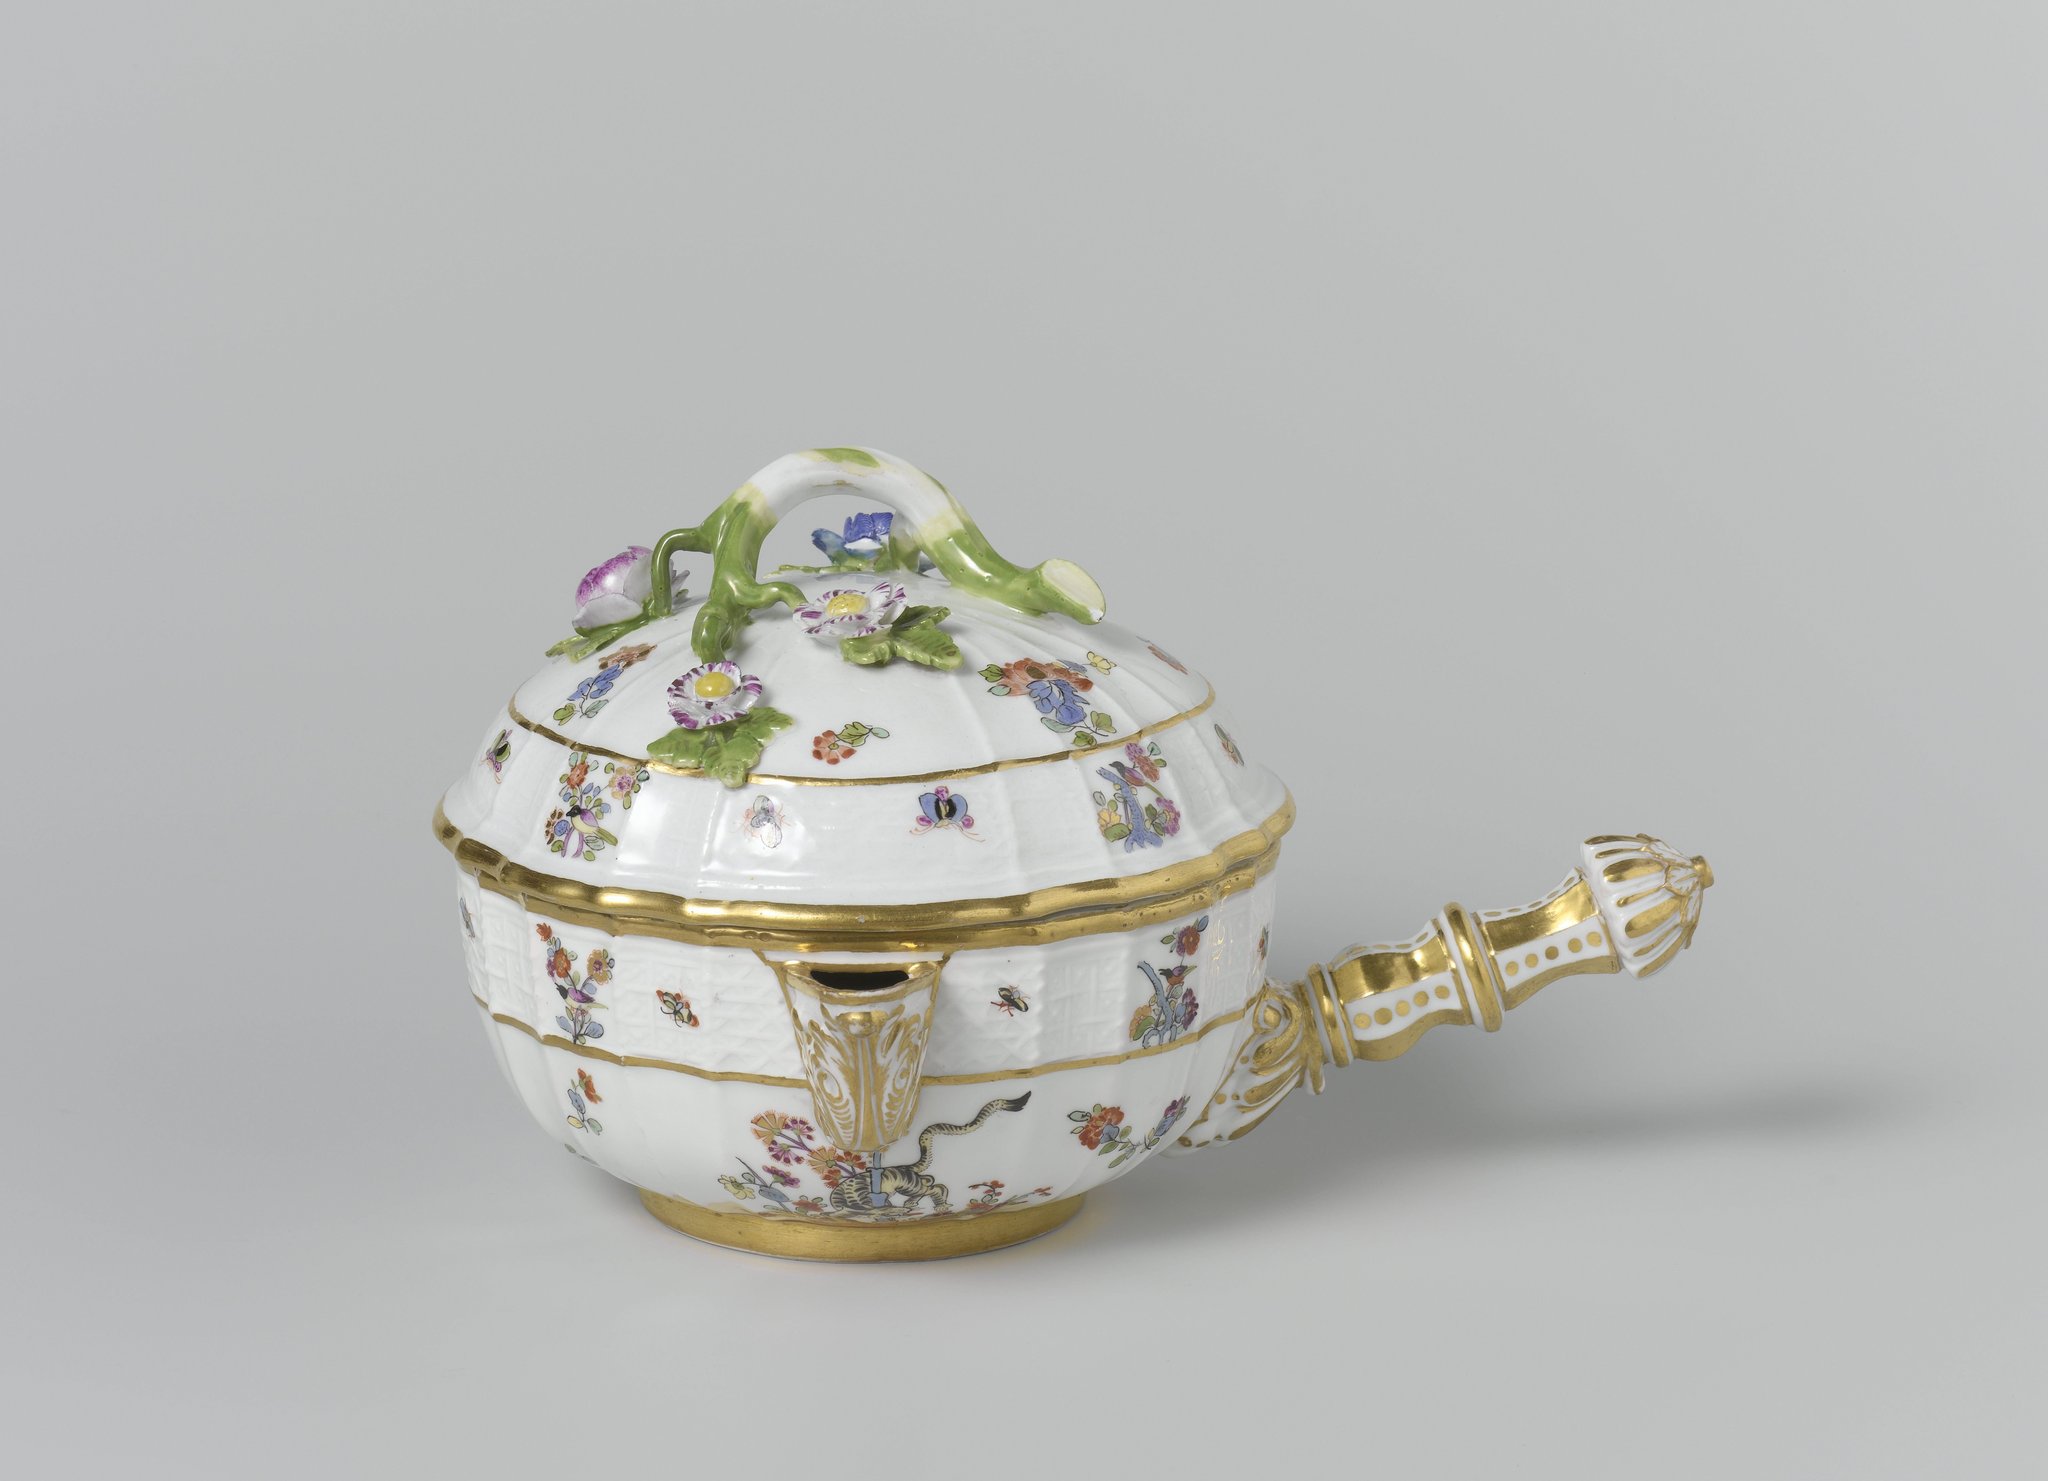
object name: tureen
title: Terrine met deksel en handvat, veelkleurig beschilderd met een Kakiemon-decor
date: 1740-1745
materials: porcelain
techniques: painted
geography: meissen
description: Half bolvormige terrine van beschilderd porselein. De terrine heeft een sneb en een geprofileerd handvat. Het halfbolvormige deksel heeft een knop in de vorm van een tak met bladeren en bloemen in reliëf. De terrine en het deksel zijn geribd en beschilderd met een tijger om een bamboestengel, gestrooide Indianische Blumen, vlinders en takken met vogels. De randen zijn versierd met het 'Altbrandenstein'-patroon.